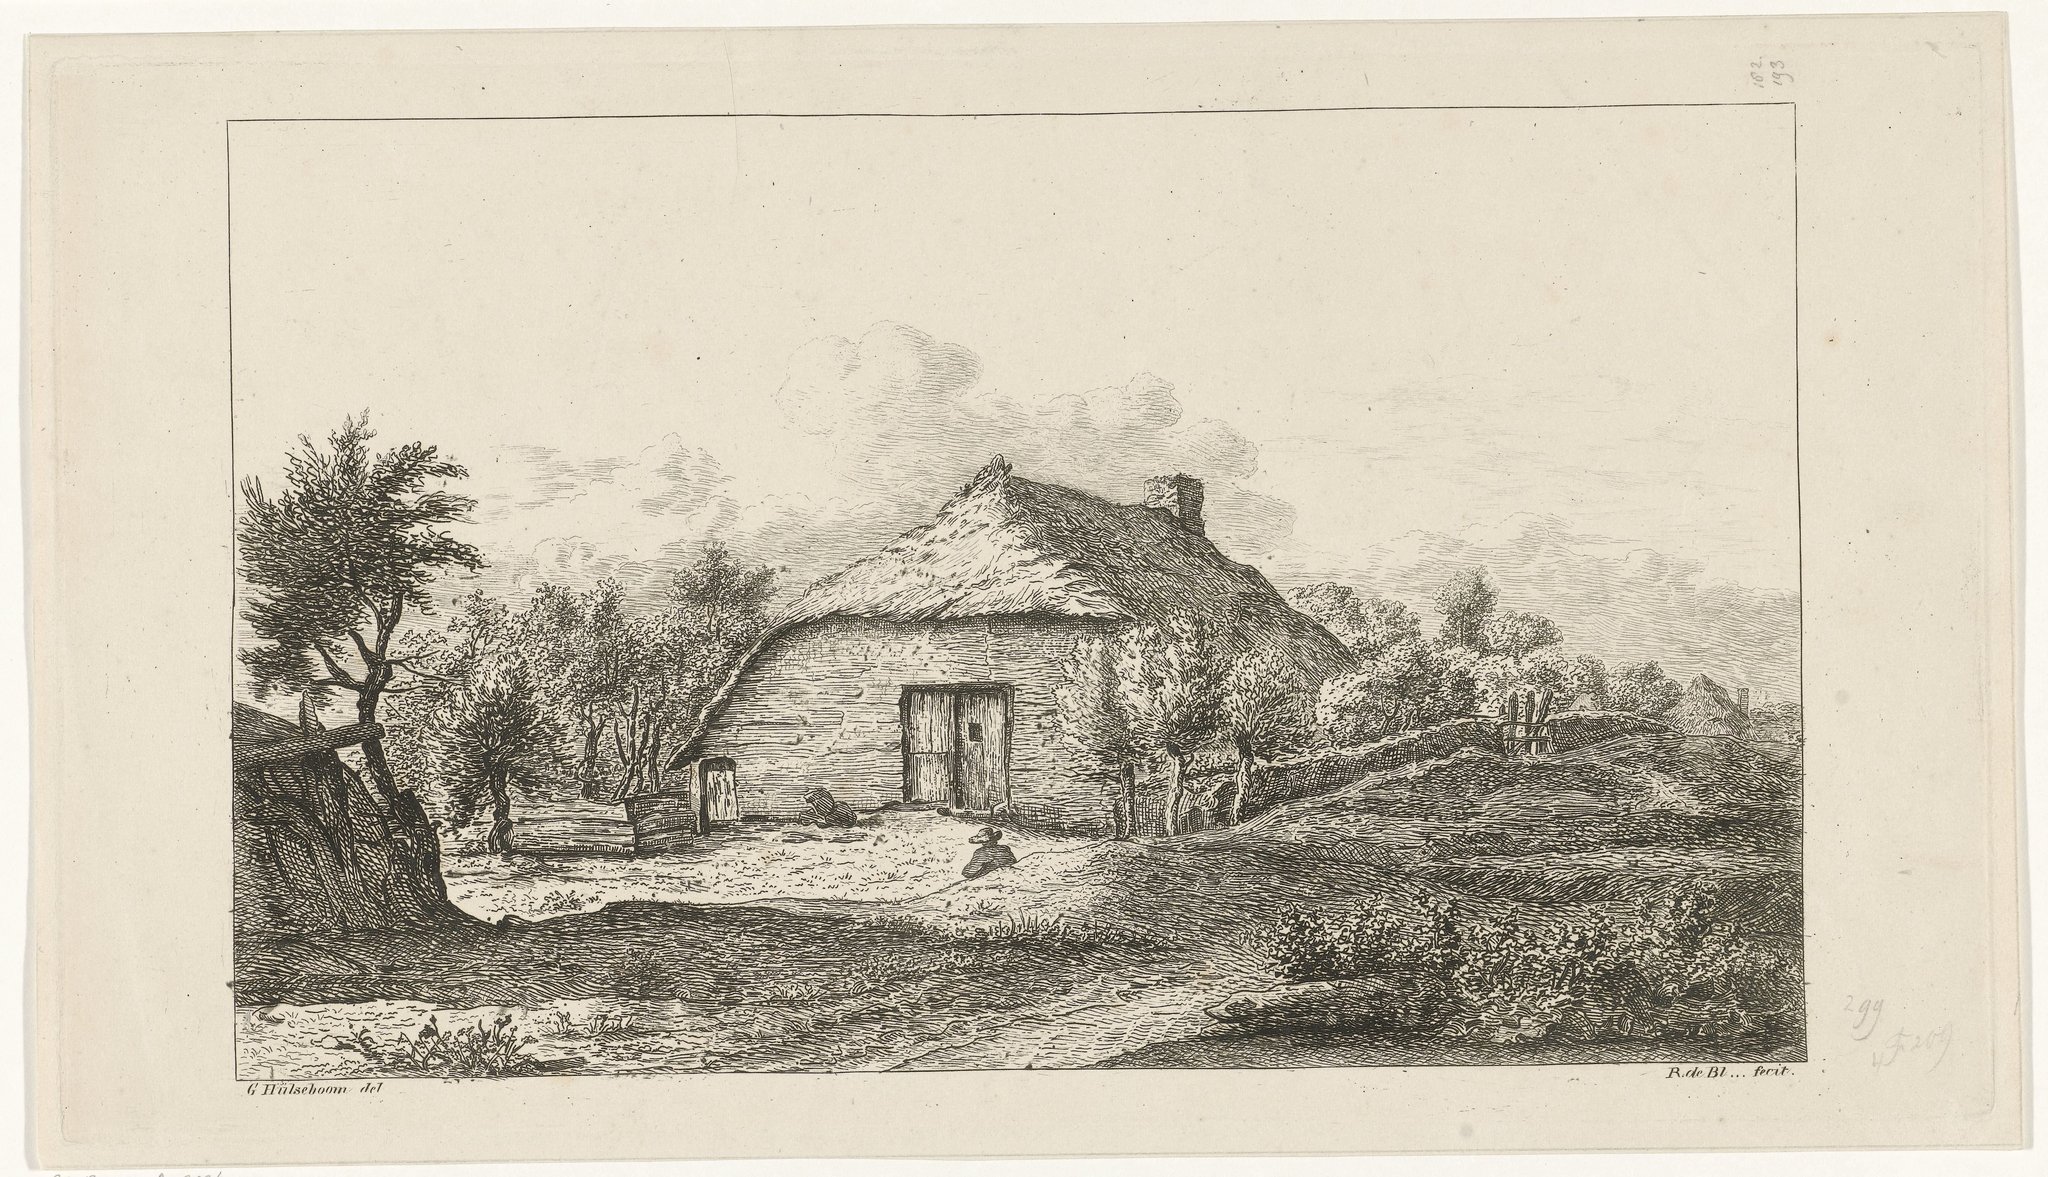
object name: print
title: Boerderij met dak van stro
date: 1796-1856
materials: paper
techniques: engraving, etching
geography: vaassen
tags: farm or solitary house in landscape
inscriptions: collector's mark: Lugt 2228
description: Een boerderij met een dak van stro. Links en achter de boerderij bomen. Op de voorgrond een man op de rug gezien.